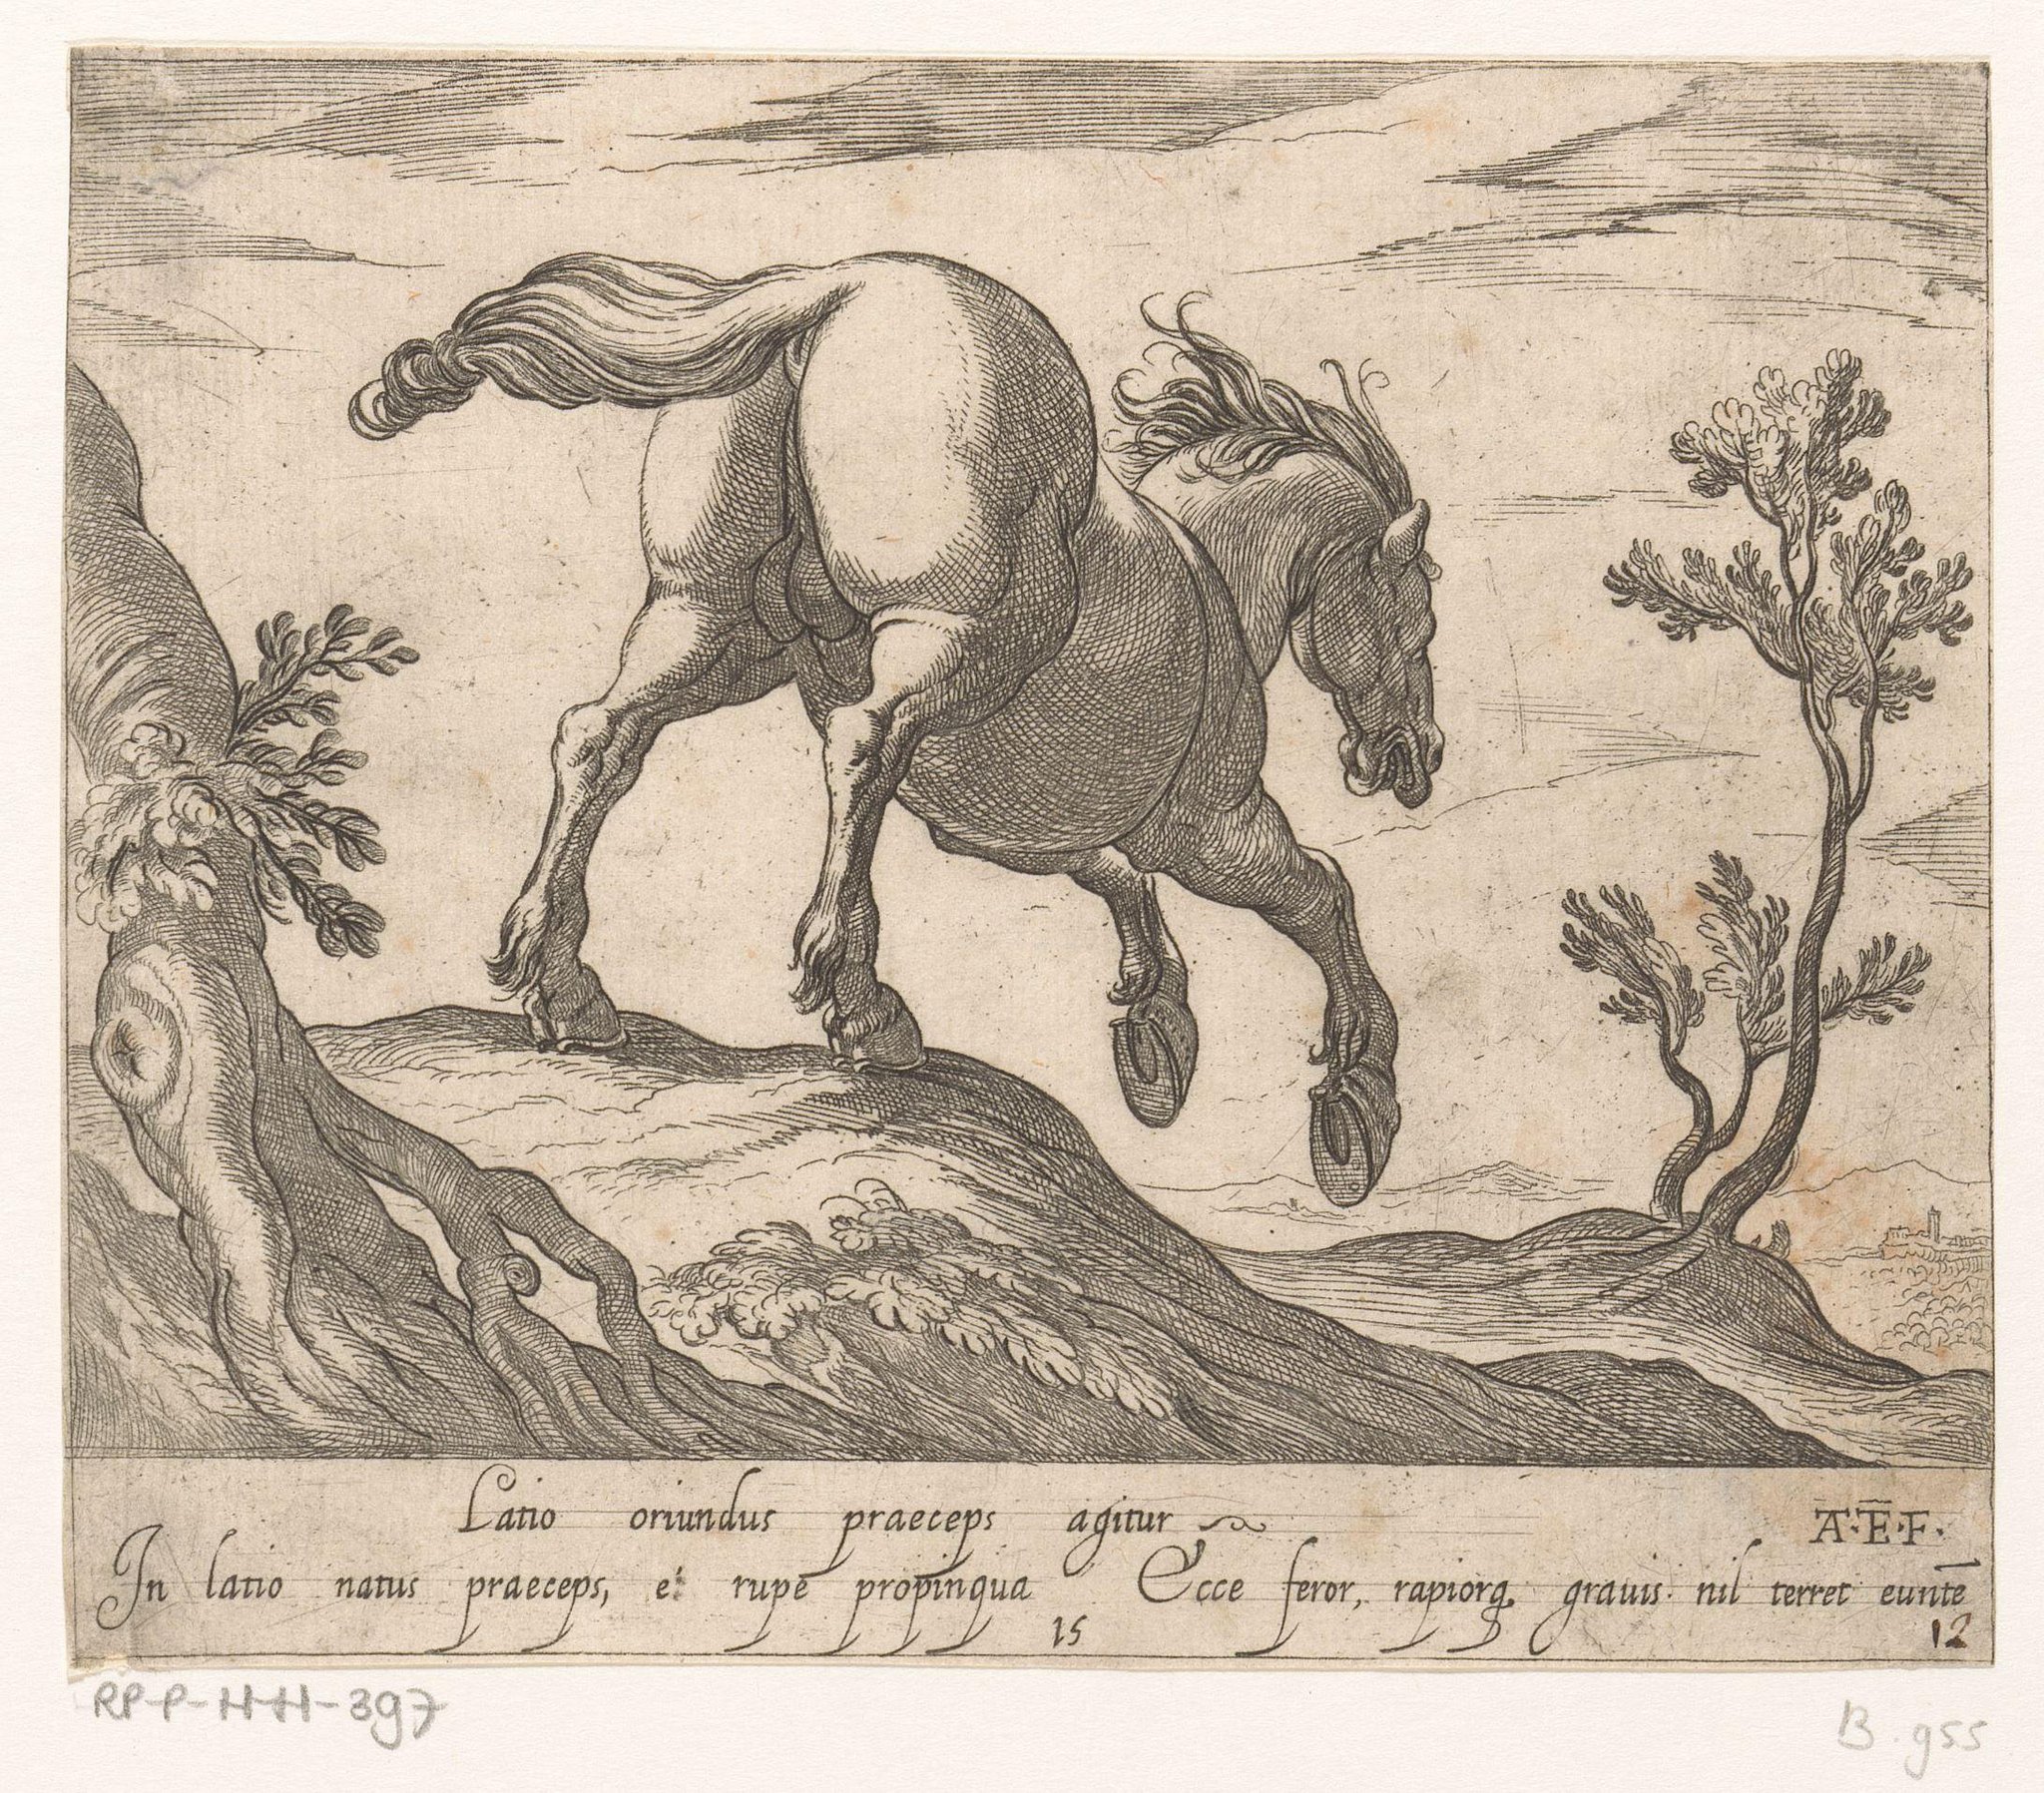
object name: print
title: His ducibus princeps celebraberis ore viroru illa homines beat haec sideribusq locat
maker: antonio tempesta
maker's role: draughtsman, painter, print maker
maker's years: 1555-1630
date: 1590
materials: paper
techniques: etching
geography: italy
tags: horse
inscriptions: number: ‘12’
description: Deze prent maakt deel uit van een reeks van 28 prenten van paarden (+ titelprent en opdracht).